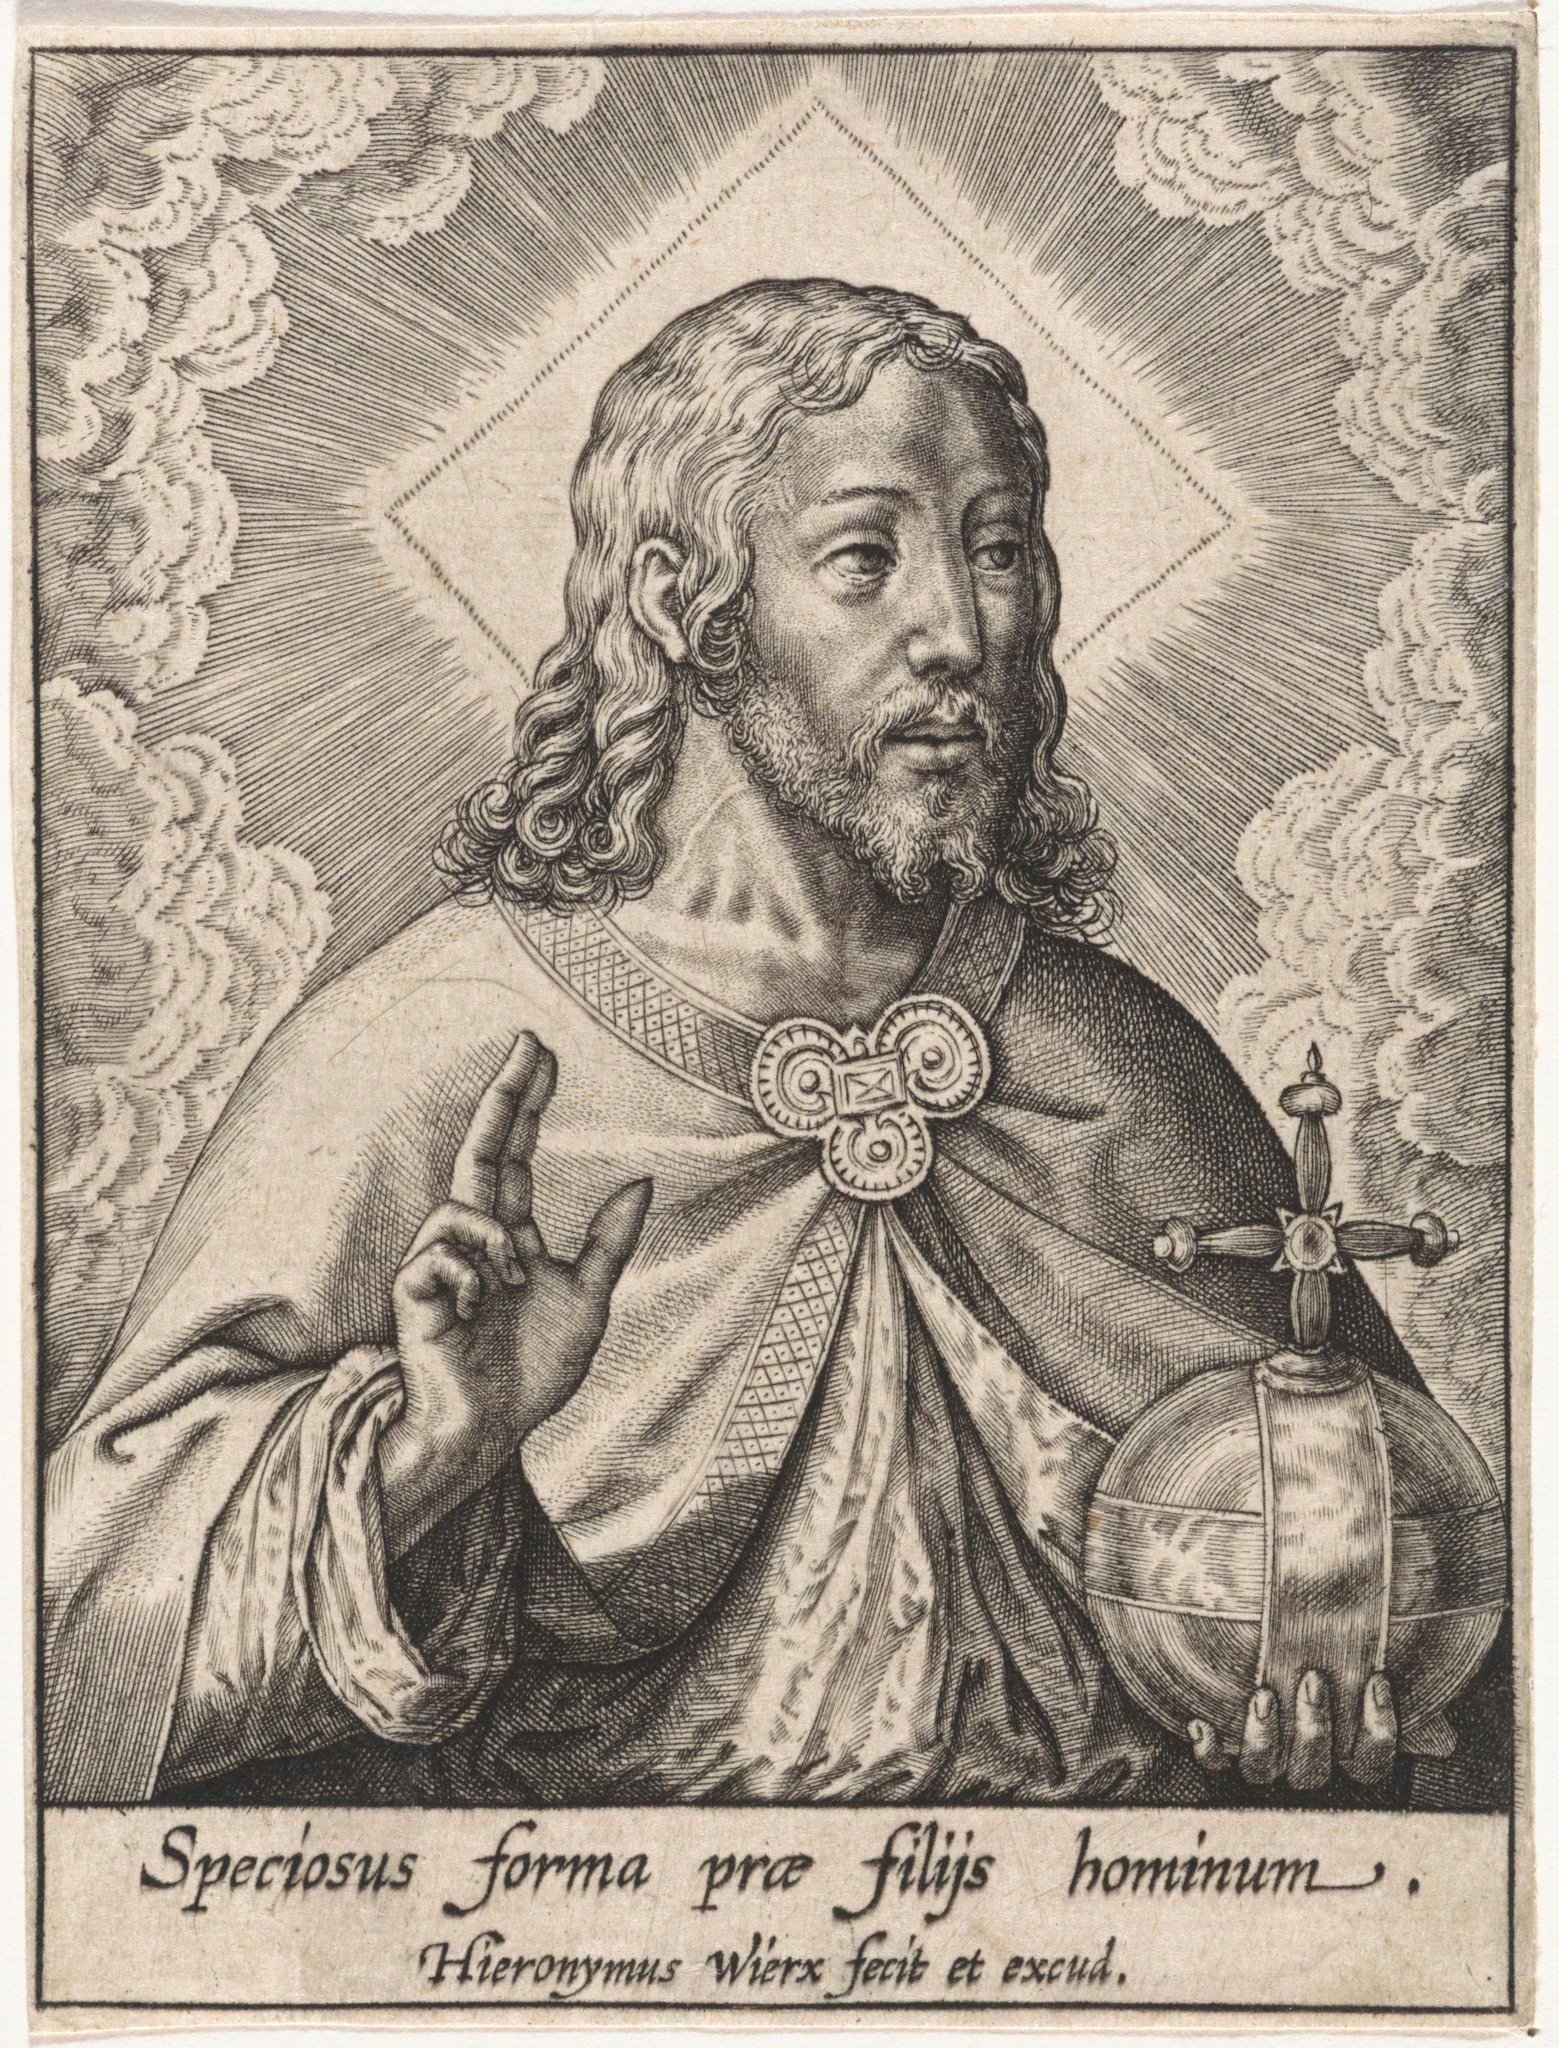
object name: print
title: Christus als Salvator Mundi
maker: hieronymus wierix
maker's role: draughtsman, print maker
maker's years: 1553-1619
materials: paper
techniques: engraving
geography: antwerp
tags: 'salvator mundi', making a blessing gesture; an orb in his hand or at his feet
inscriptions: number: ‘38 - 27’, collector's mark: Lugt 240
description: Christus houdt een rijksappel in de ene hand, en maakt een zegenend gebaar met de ander hand. In de marge een onderschrift in het Latijn.